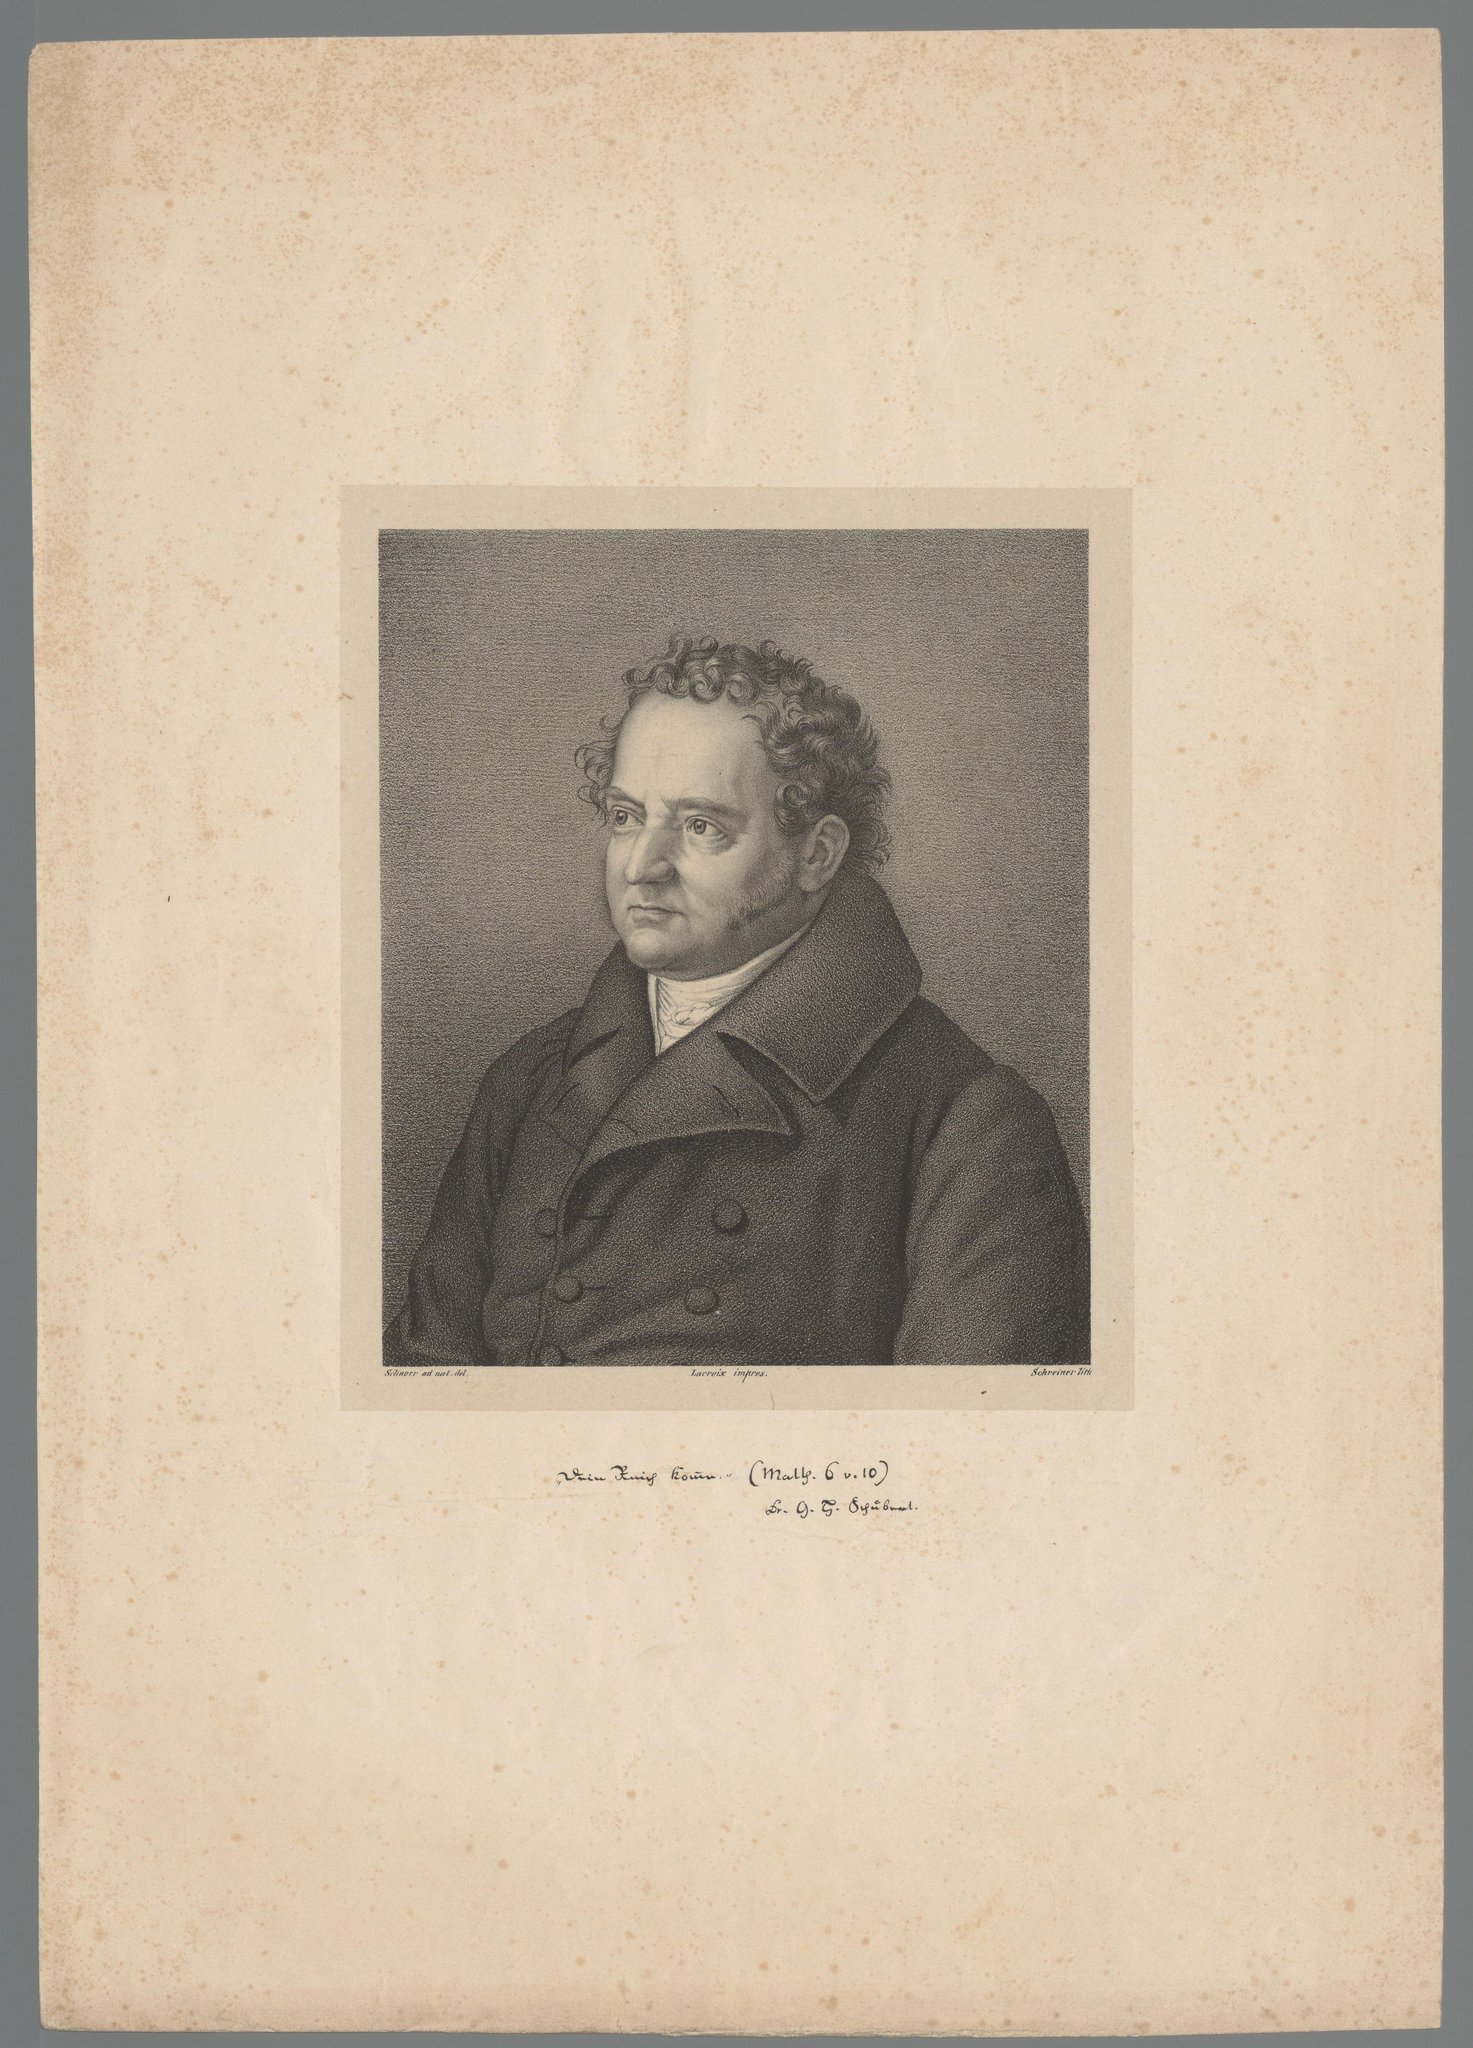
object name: print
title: Portret van Gotthilf Heinrich von Schubert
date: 1821-1853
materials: paper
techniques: lithograph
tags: gotthilf heinrich von schubert, historical persons, physician, doctor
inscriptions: collector's mark: Lugt 2228